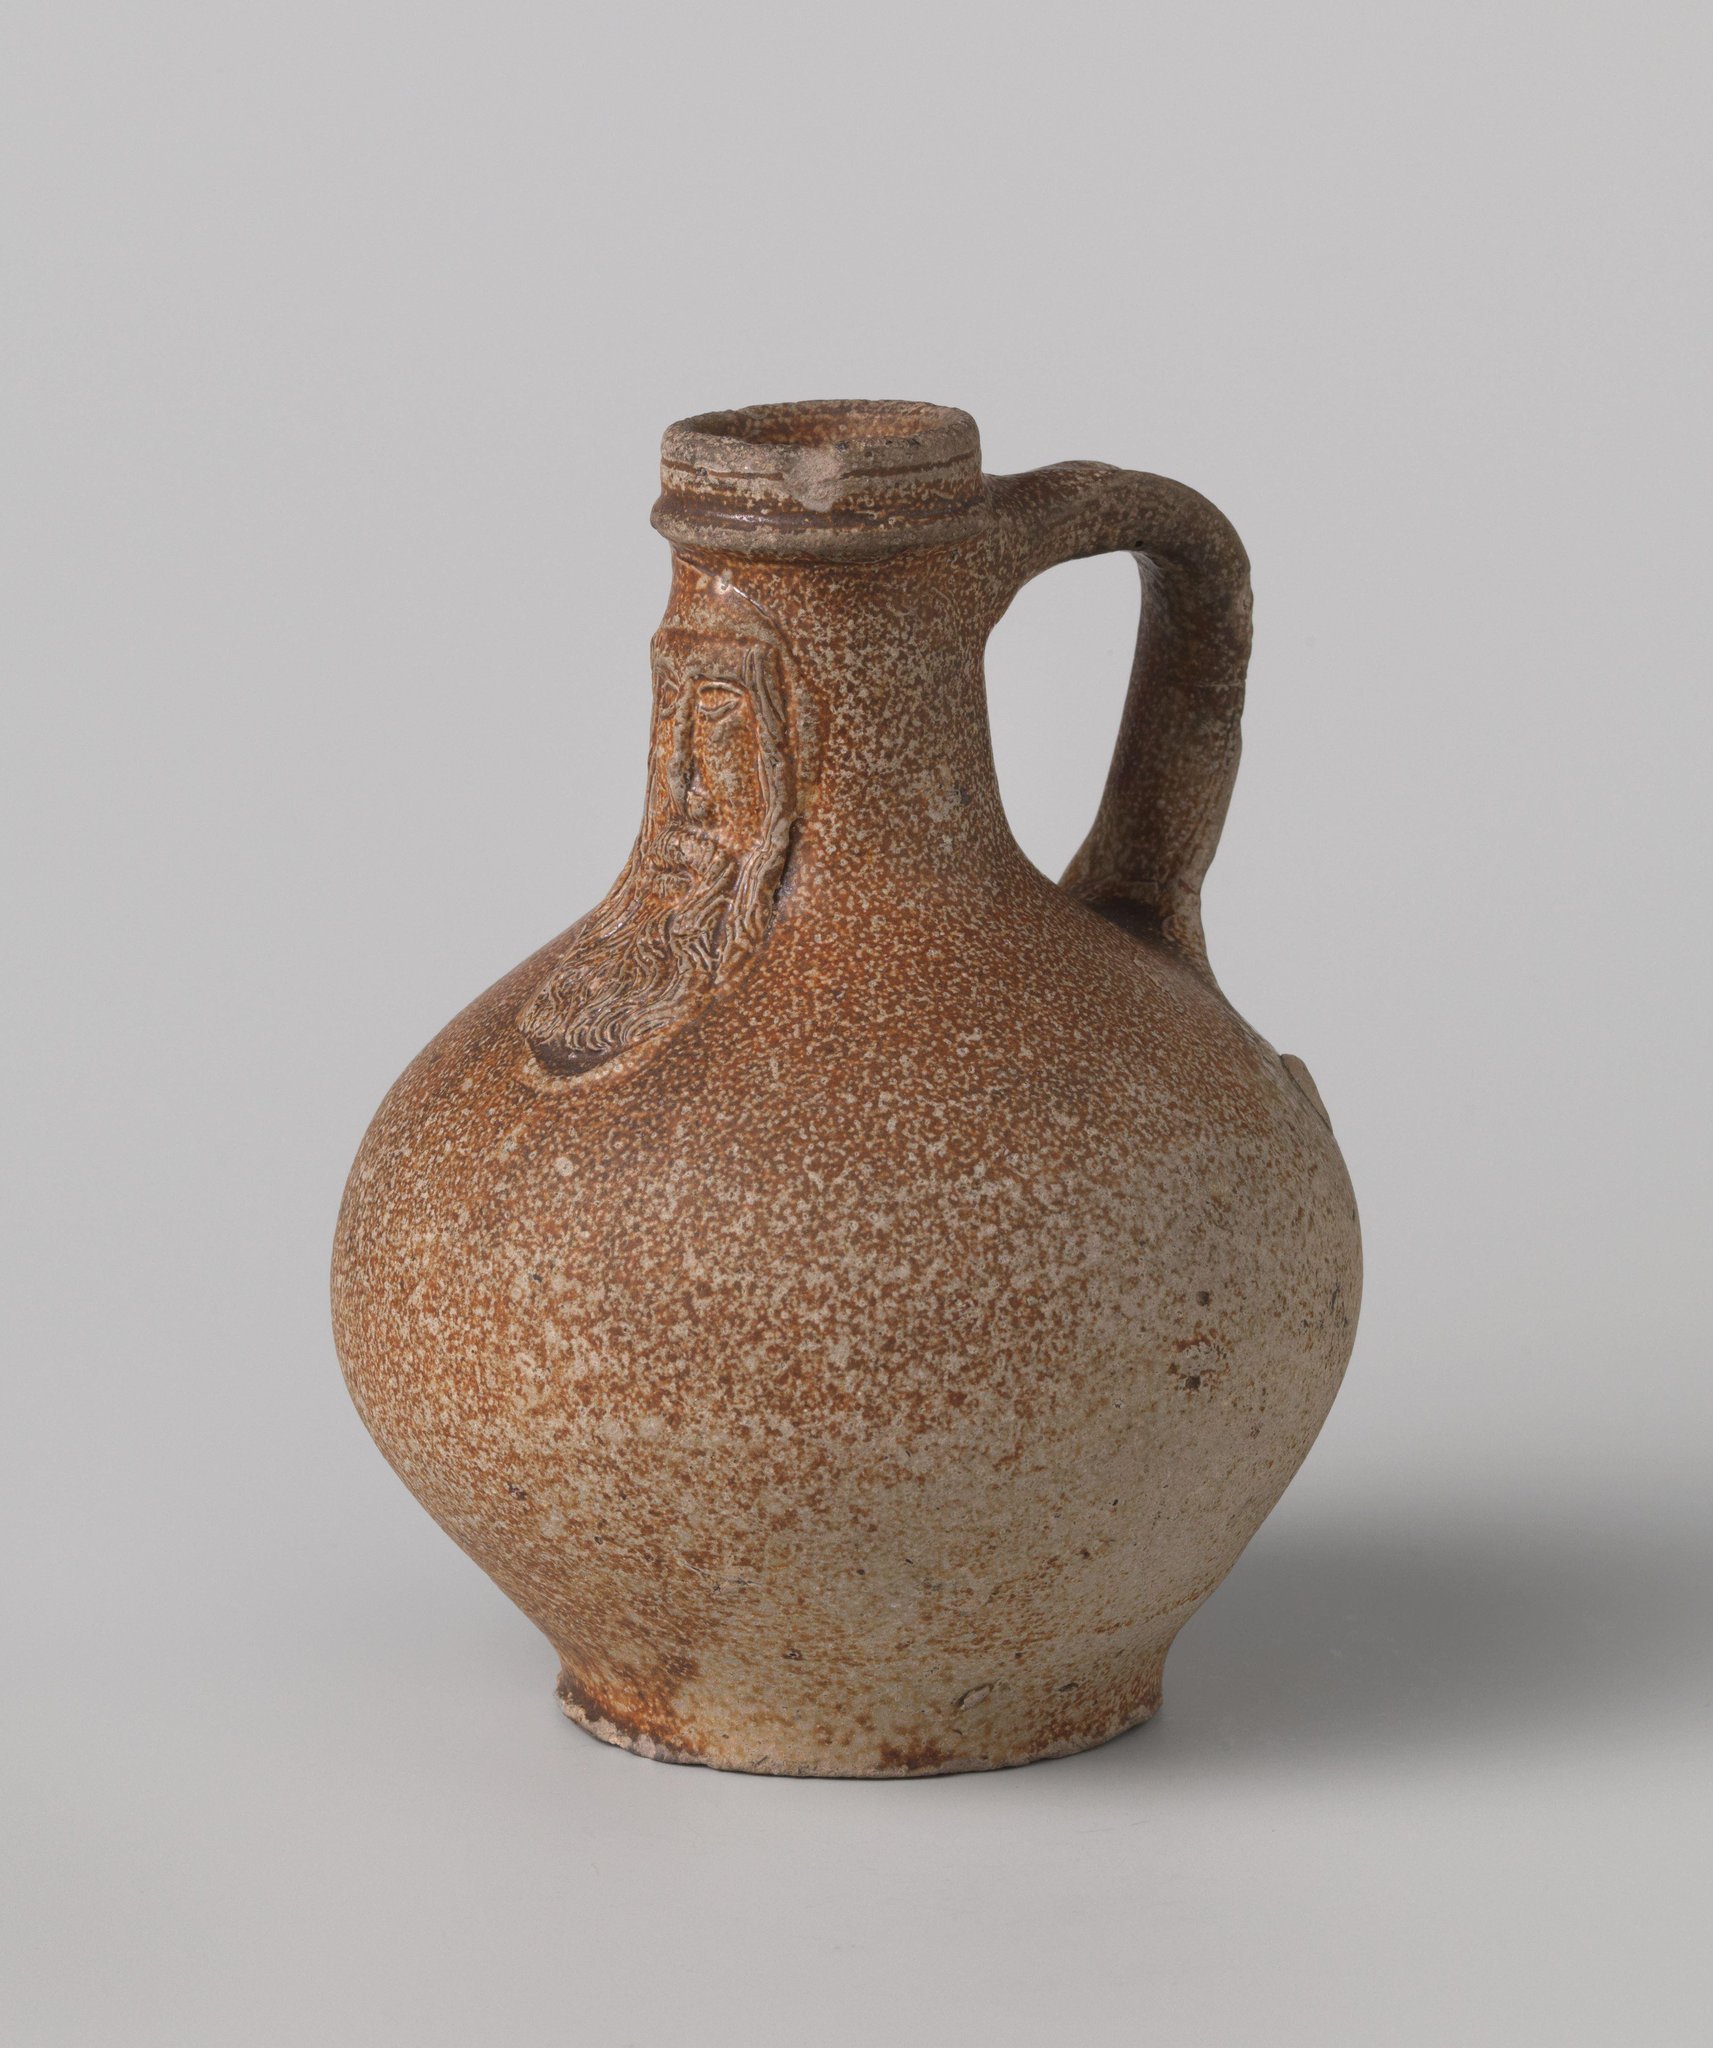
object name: jug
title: Jug (Bartmann jug)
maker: Anonymous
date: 1625-1750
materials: engobe, glaze, stoneware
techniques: firing, forming, relief, turning, vitrification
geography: frechen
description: Kruik (baardmankruik) van steengoed op standvlak met een bolvormig lichaam en smalle nek. Het C-vormige oor is bevestigd aan de nek en de schouder. Profielen op de nek en, doorlopend op de schouder, een gedrukte en opgelegde baardman in reliëf. Frechen.